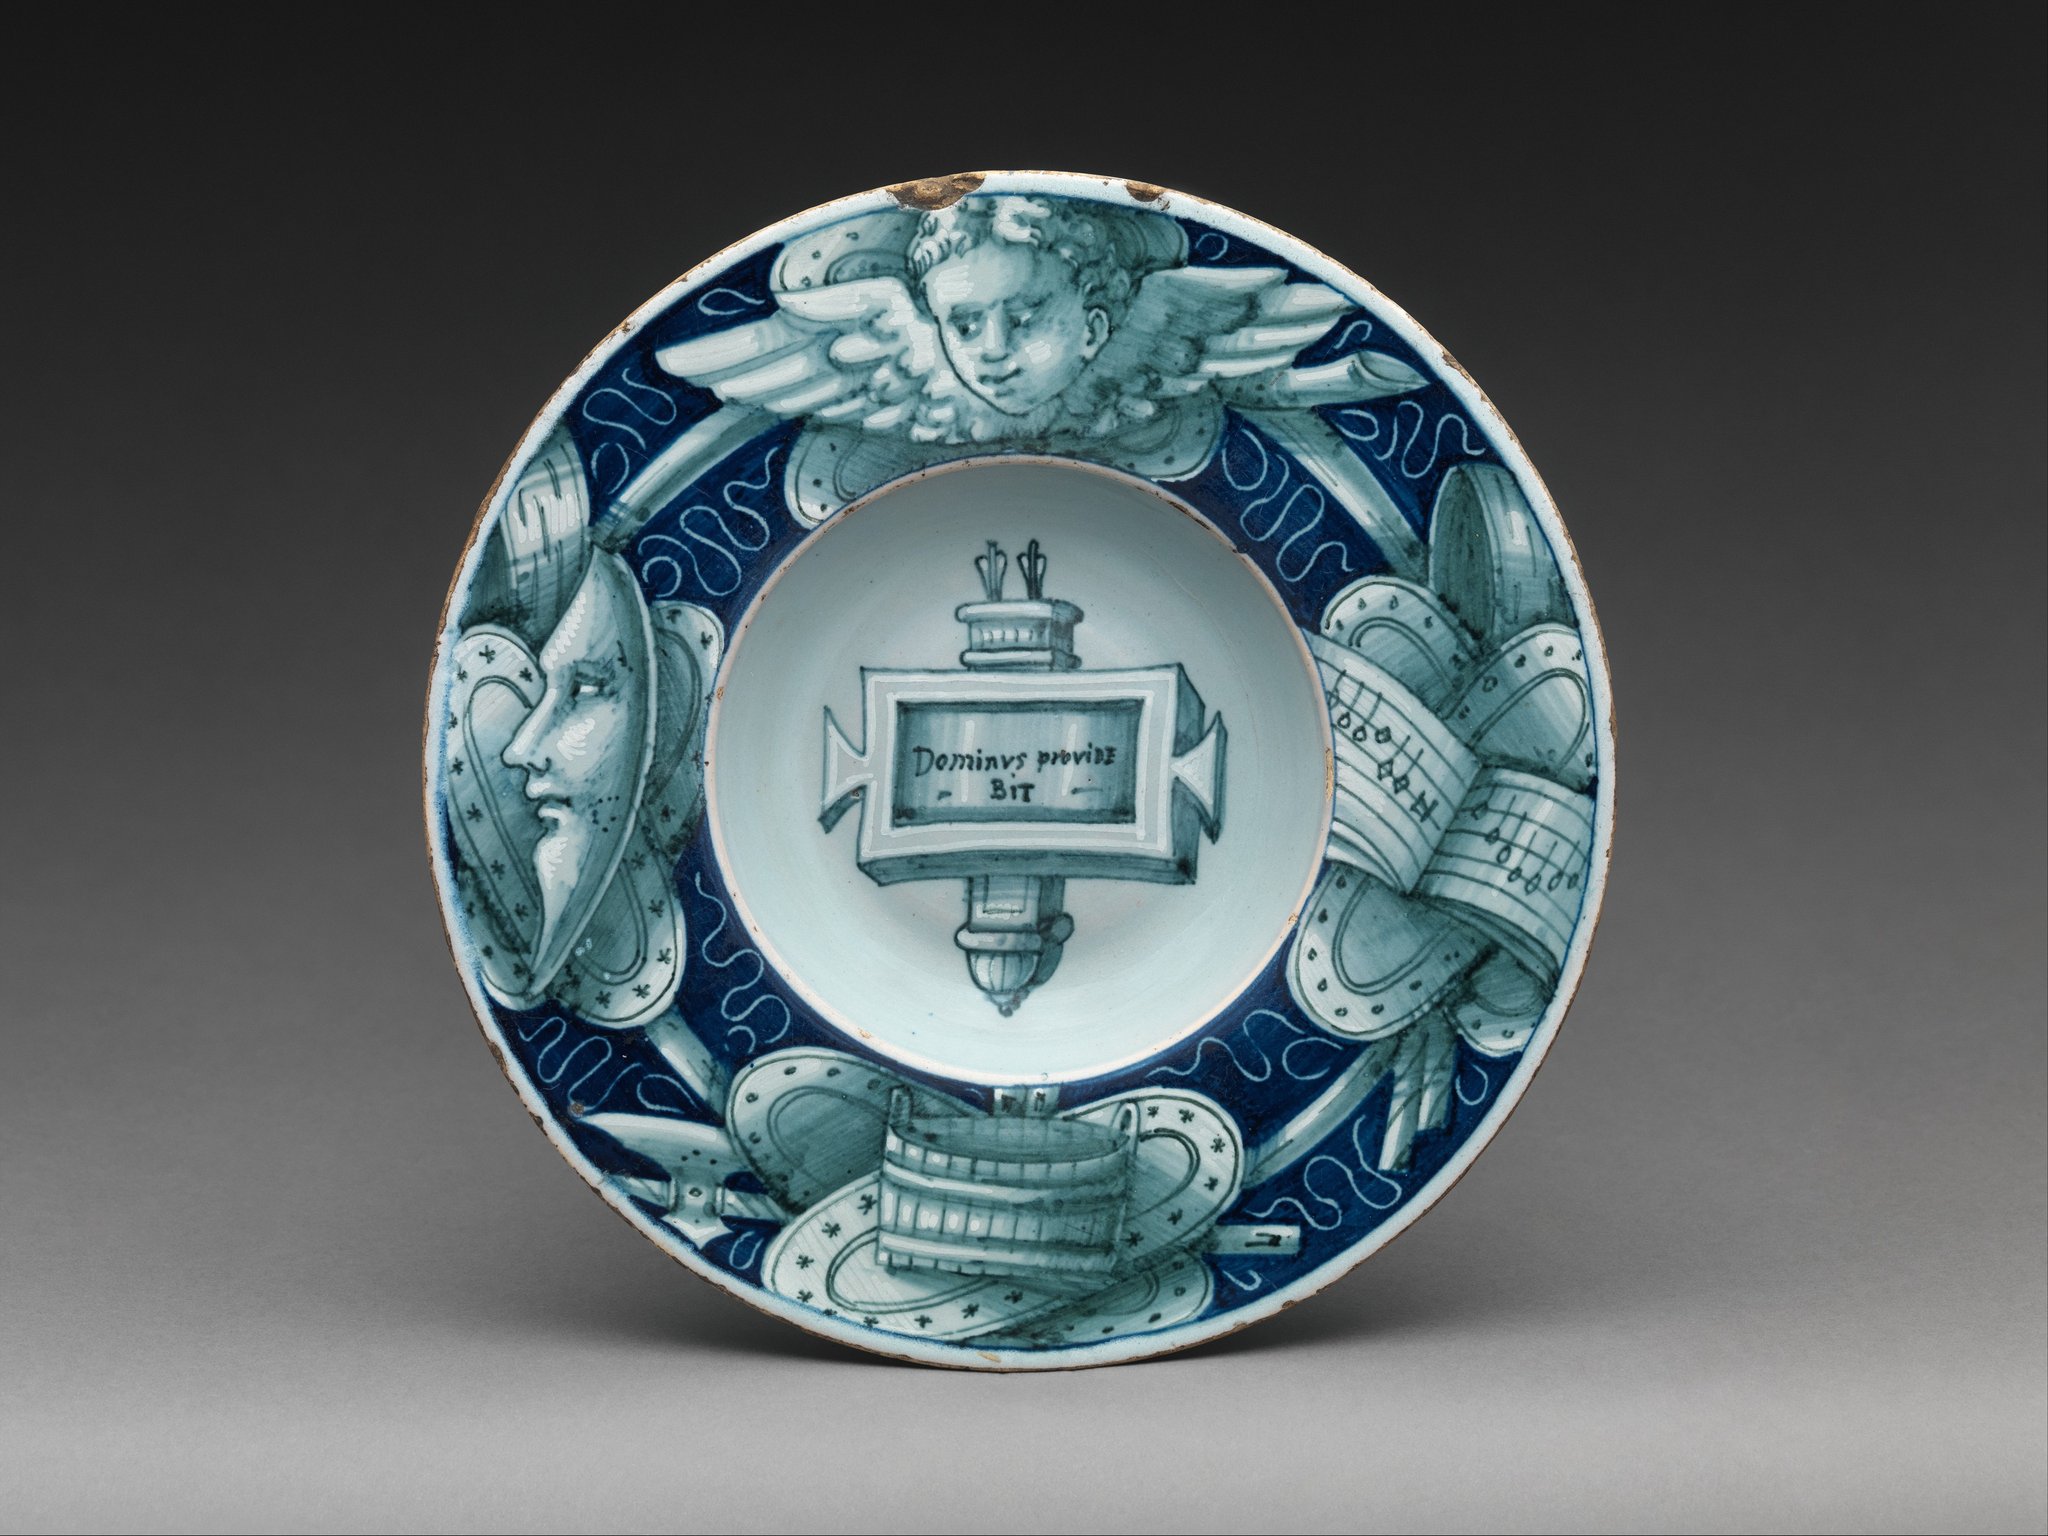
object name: bowl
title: Wide-rimmed bowl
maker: jacopo da pesaro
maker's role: artist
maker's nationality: italian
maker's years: 1507-1555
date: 1530-1550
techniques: maiolica, glazing